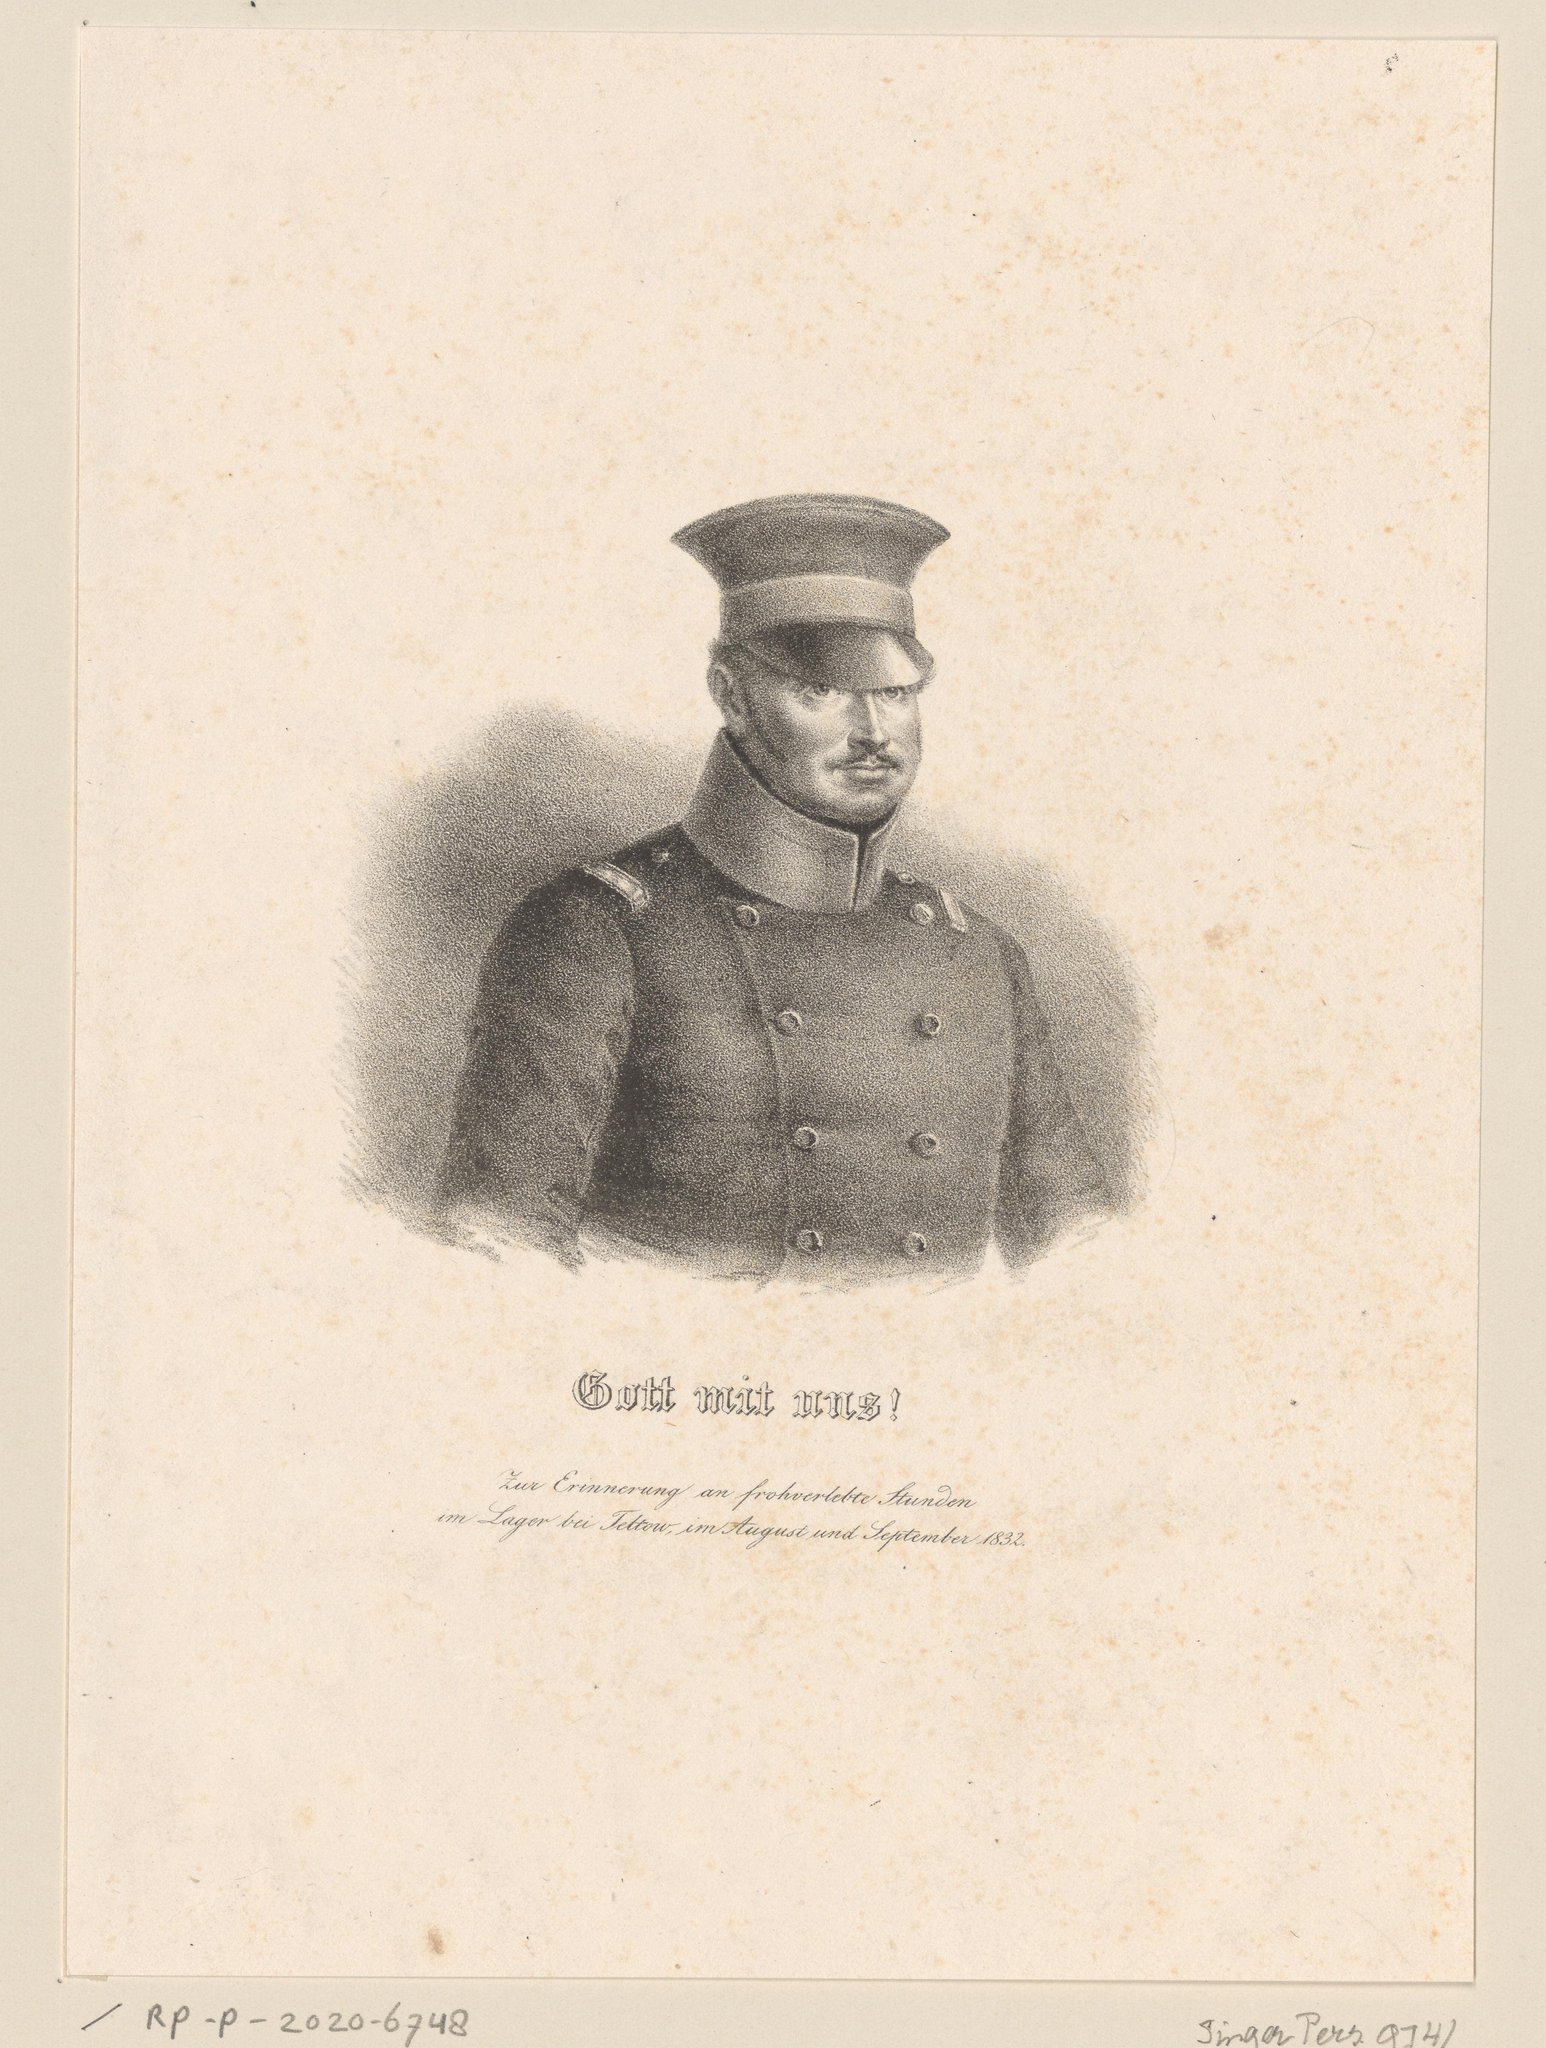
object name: print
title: Portret van waarschijnlijk Frederik Willem III van Pruisen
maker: Anonymous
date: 1832-1834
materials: paper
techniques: lithograph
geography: germany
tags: berlin, frederik willem iii koning van pruisen, historical persons, king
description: Met onderschrift in het Duits: Gott mit uns! Zur Erinnerung an frohverlebte Stunden im Lager bei Teltow, im August und September 1832.